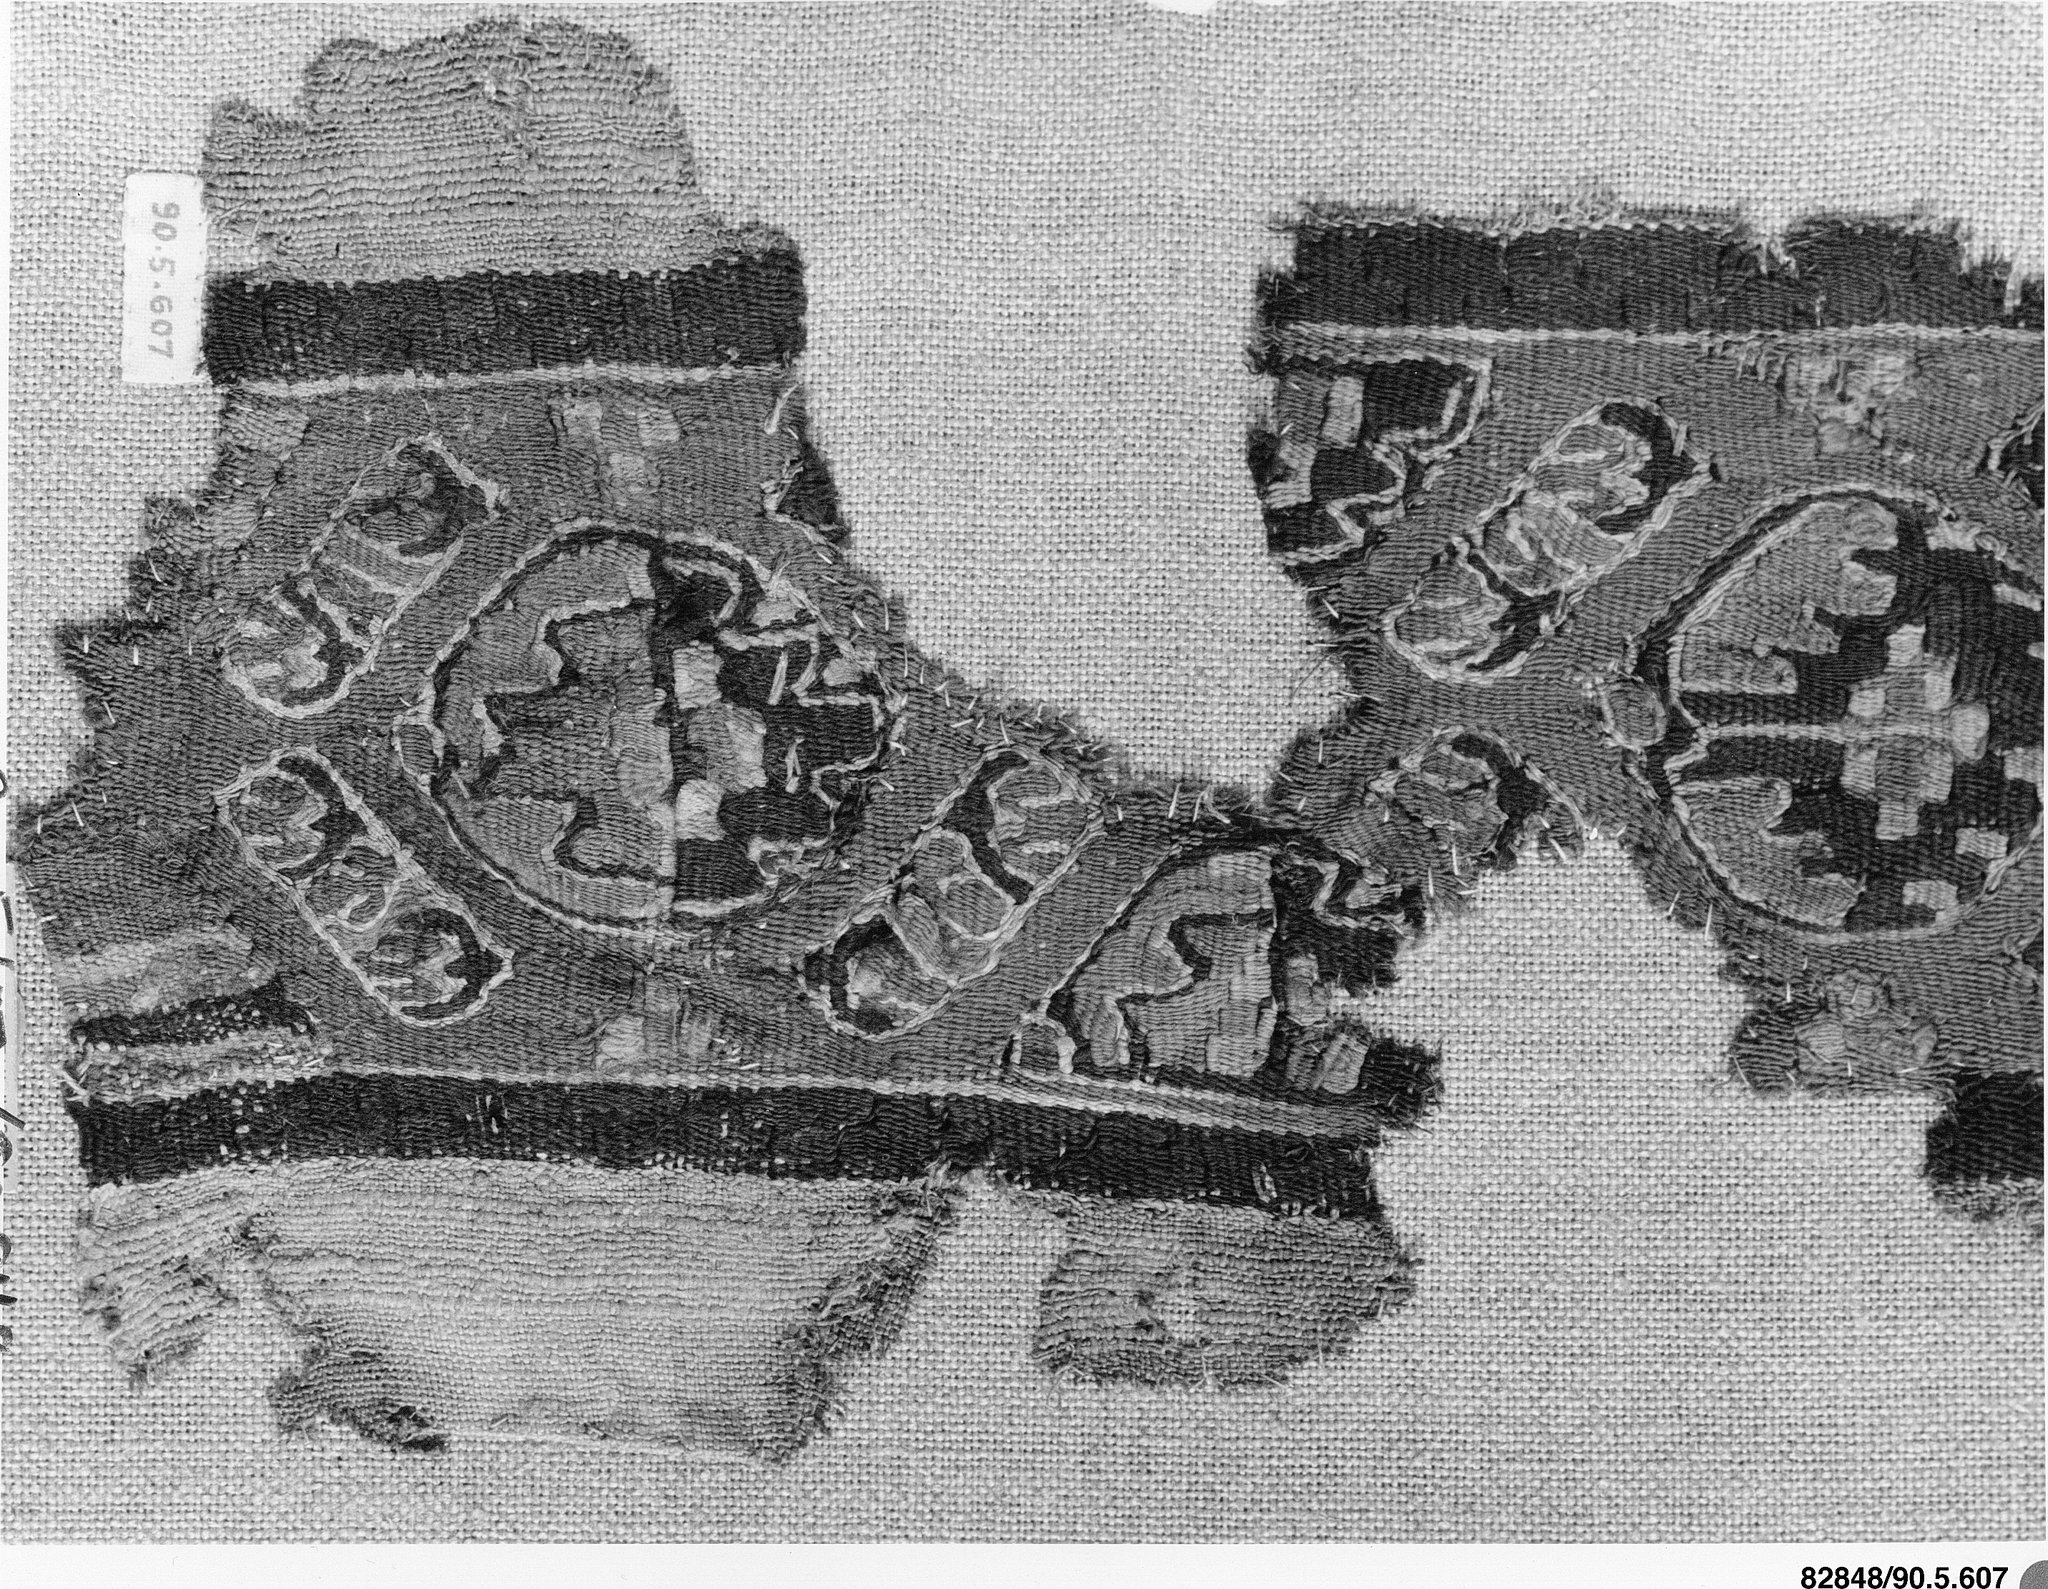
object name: textile fragment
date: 401-600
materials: linen, wool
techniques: weave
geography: egypt